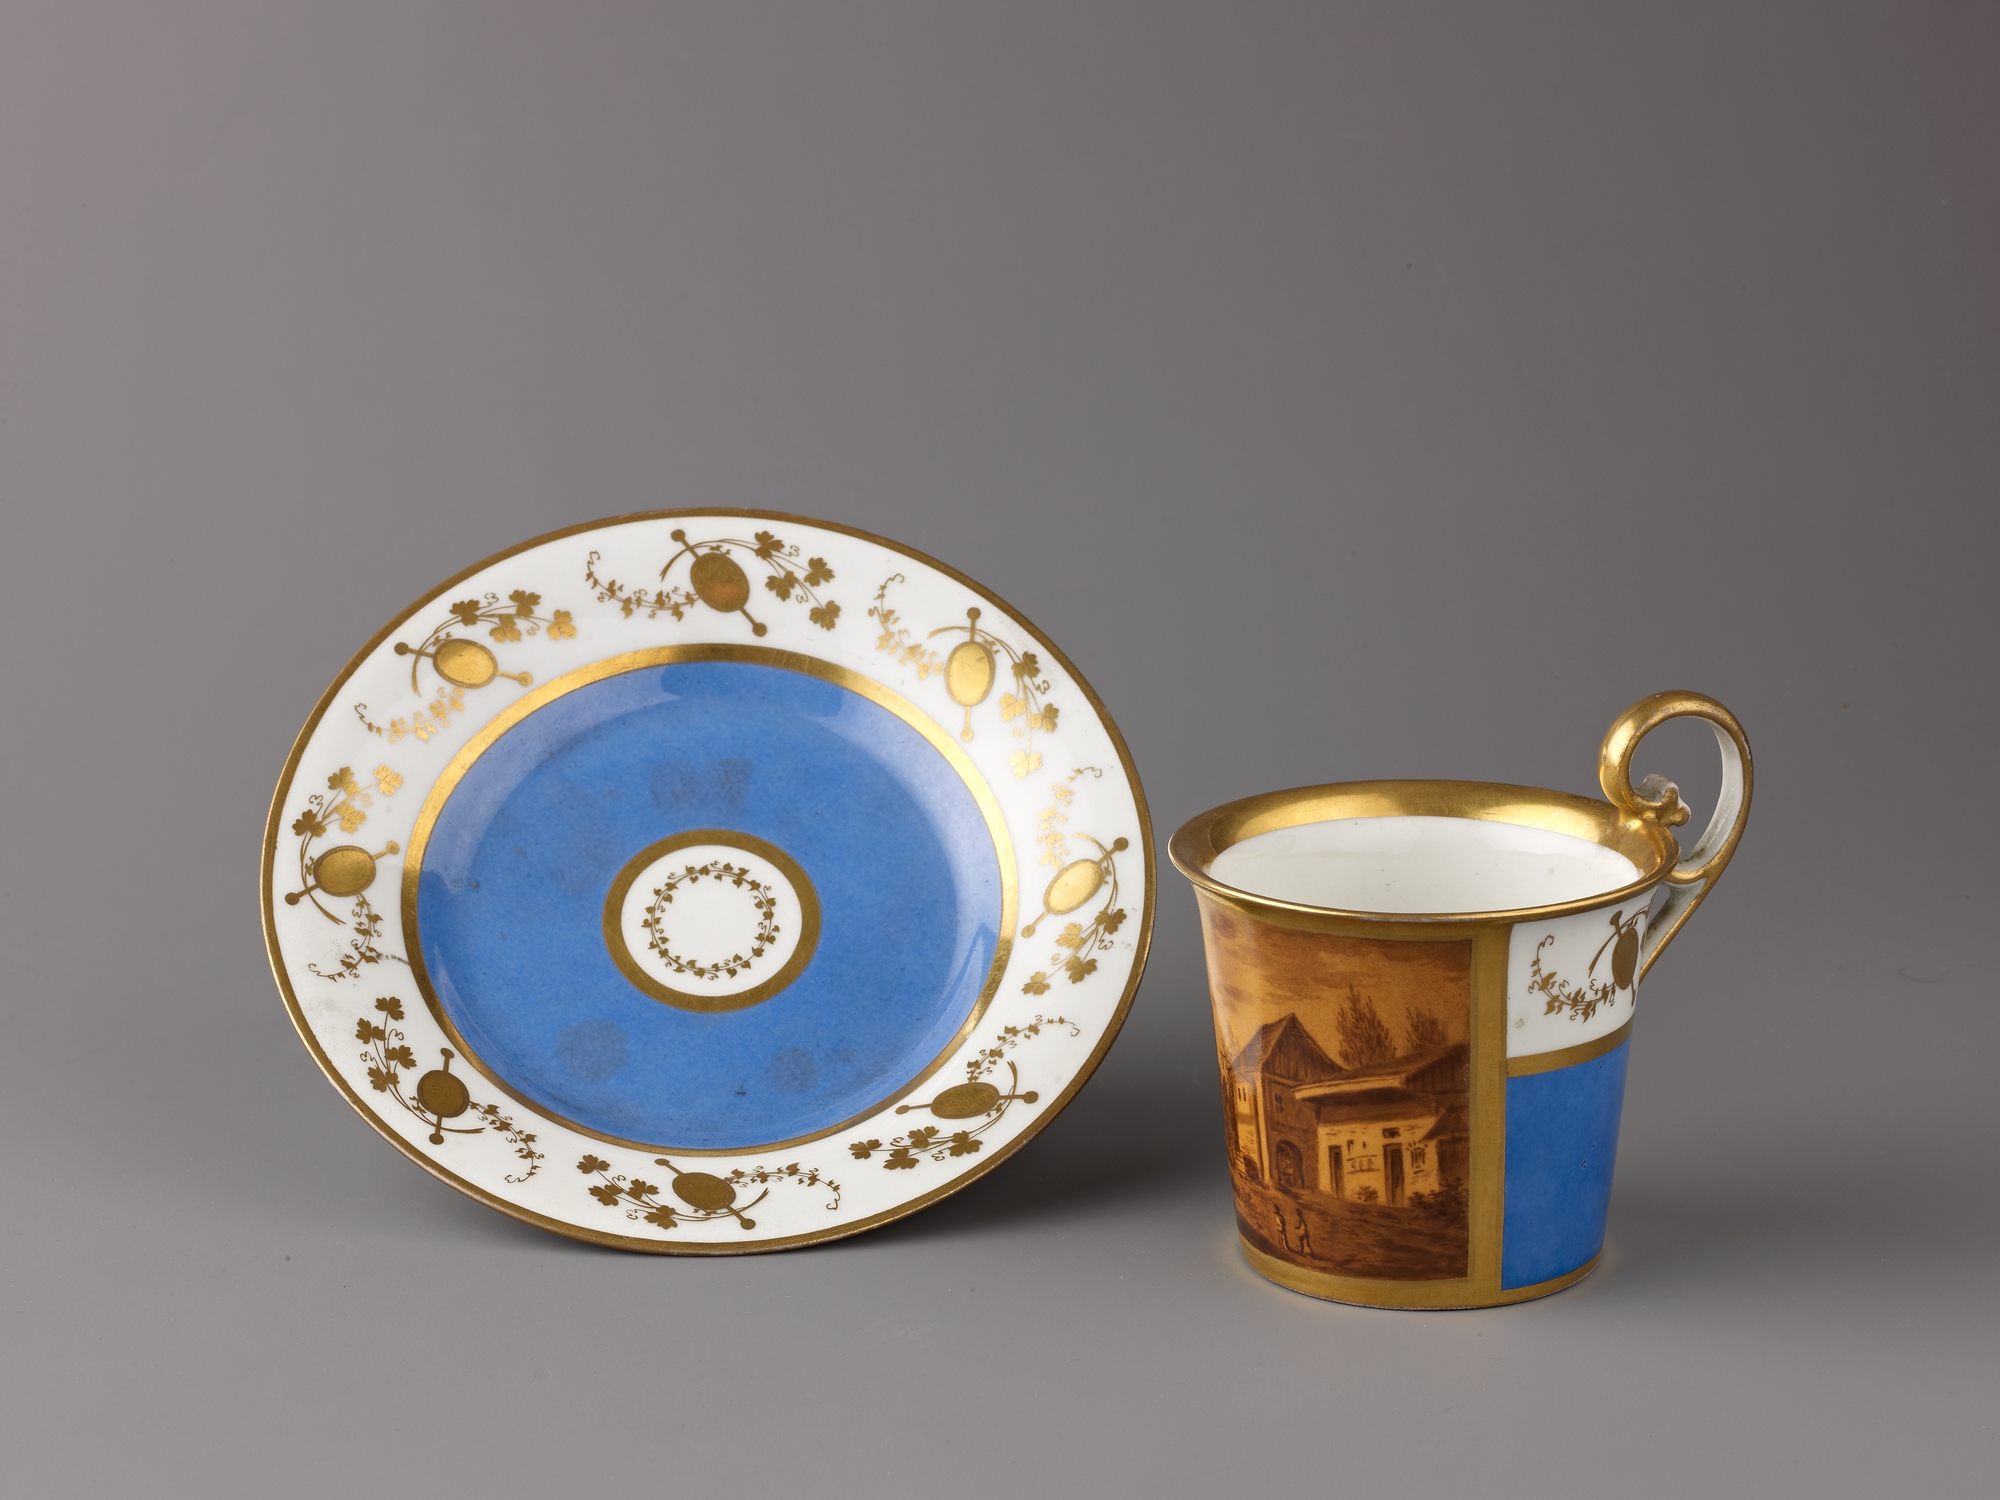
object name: cup and saucer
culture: austrian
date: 1822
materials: hard paste porcelain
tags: houses